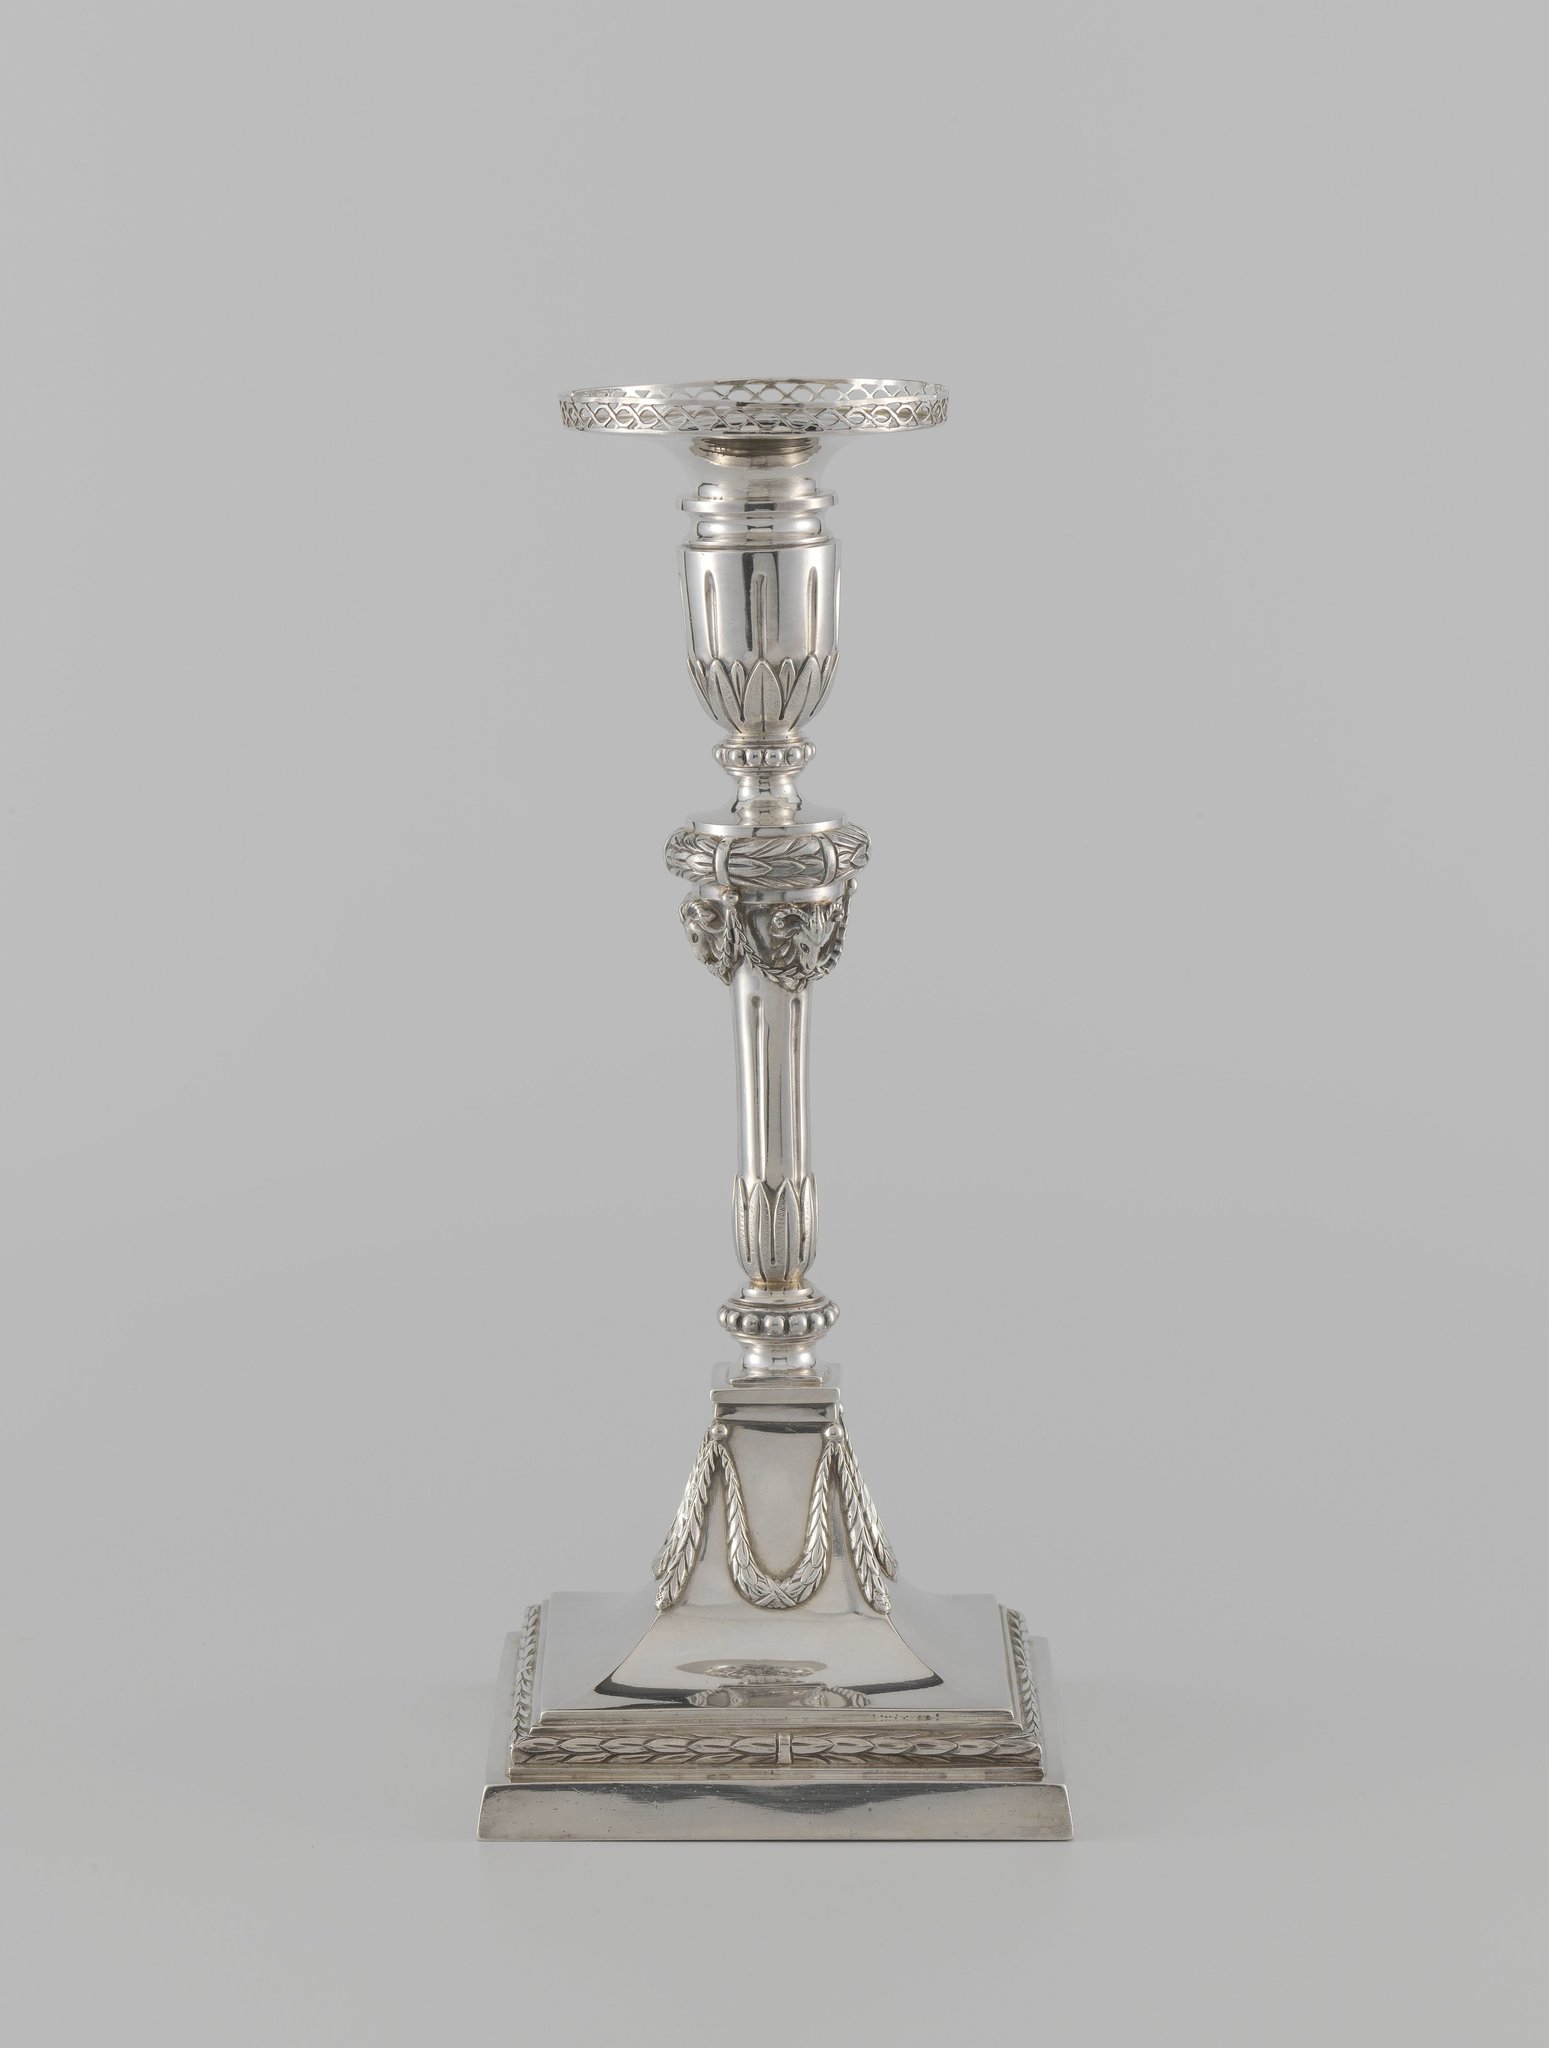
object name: candlestick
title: Kandelaar van zilver met vierkante voet en ronde stam, kaarsenhouder en losse vetvanger.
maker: johannes henricus pluygers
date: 1783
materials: silver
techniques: casting, metalworking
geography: the hague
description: Kandelaar bestaande uit een vierkante voet en een ronde stam, kaarsenhouder en losse vetvanger. Gemerkt en gedateerd.